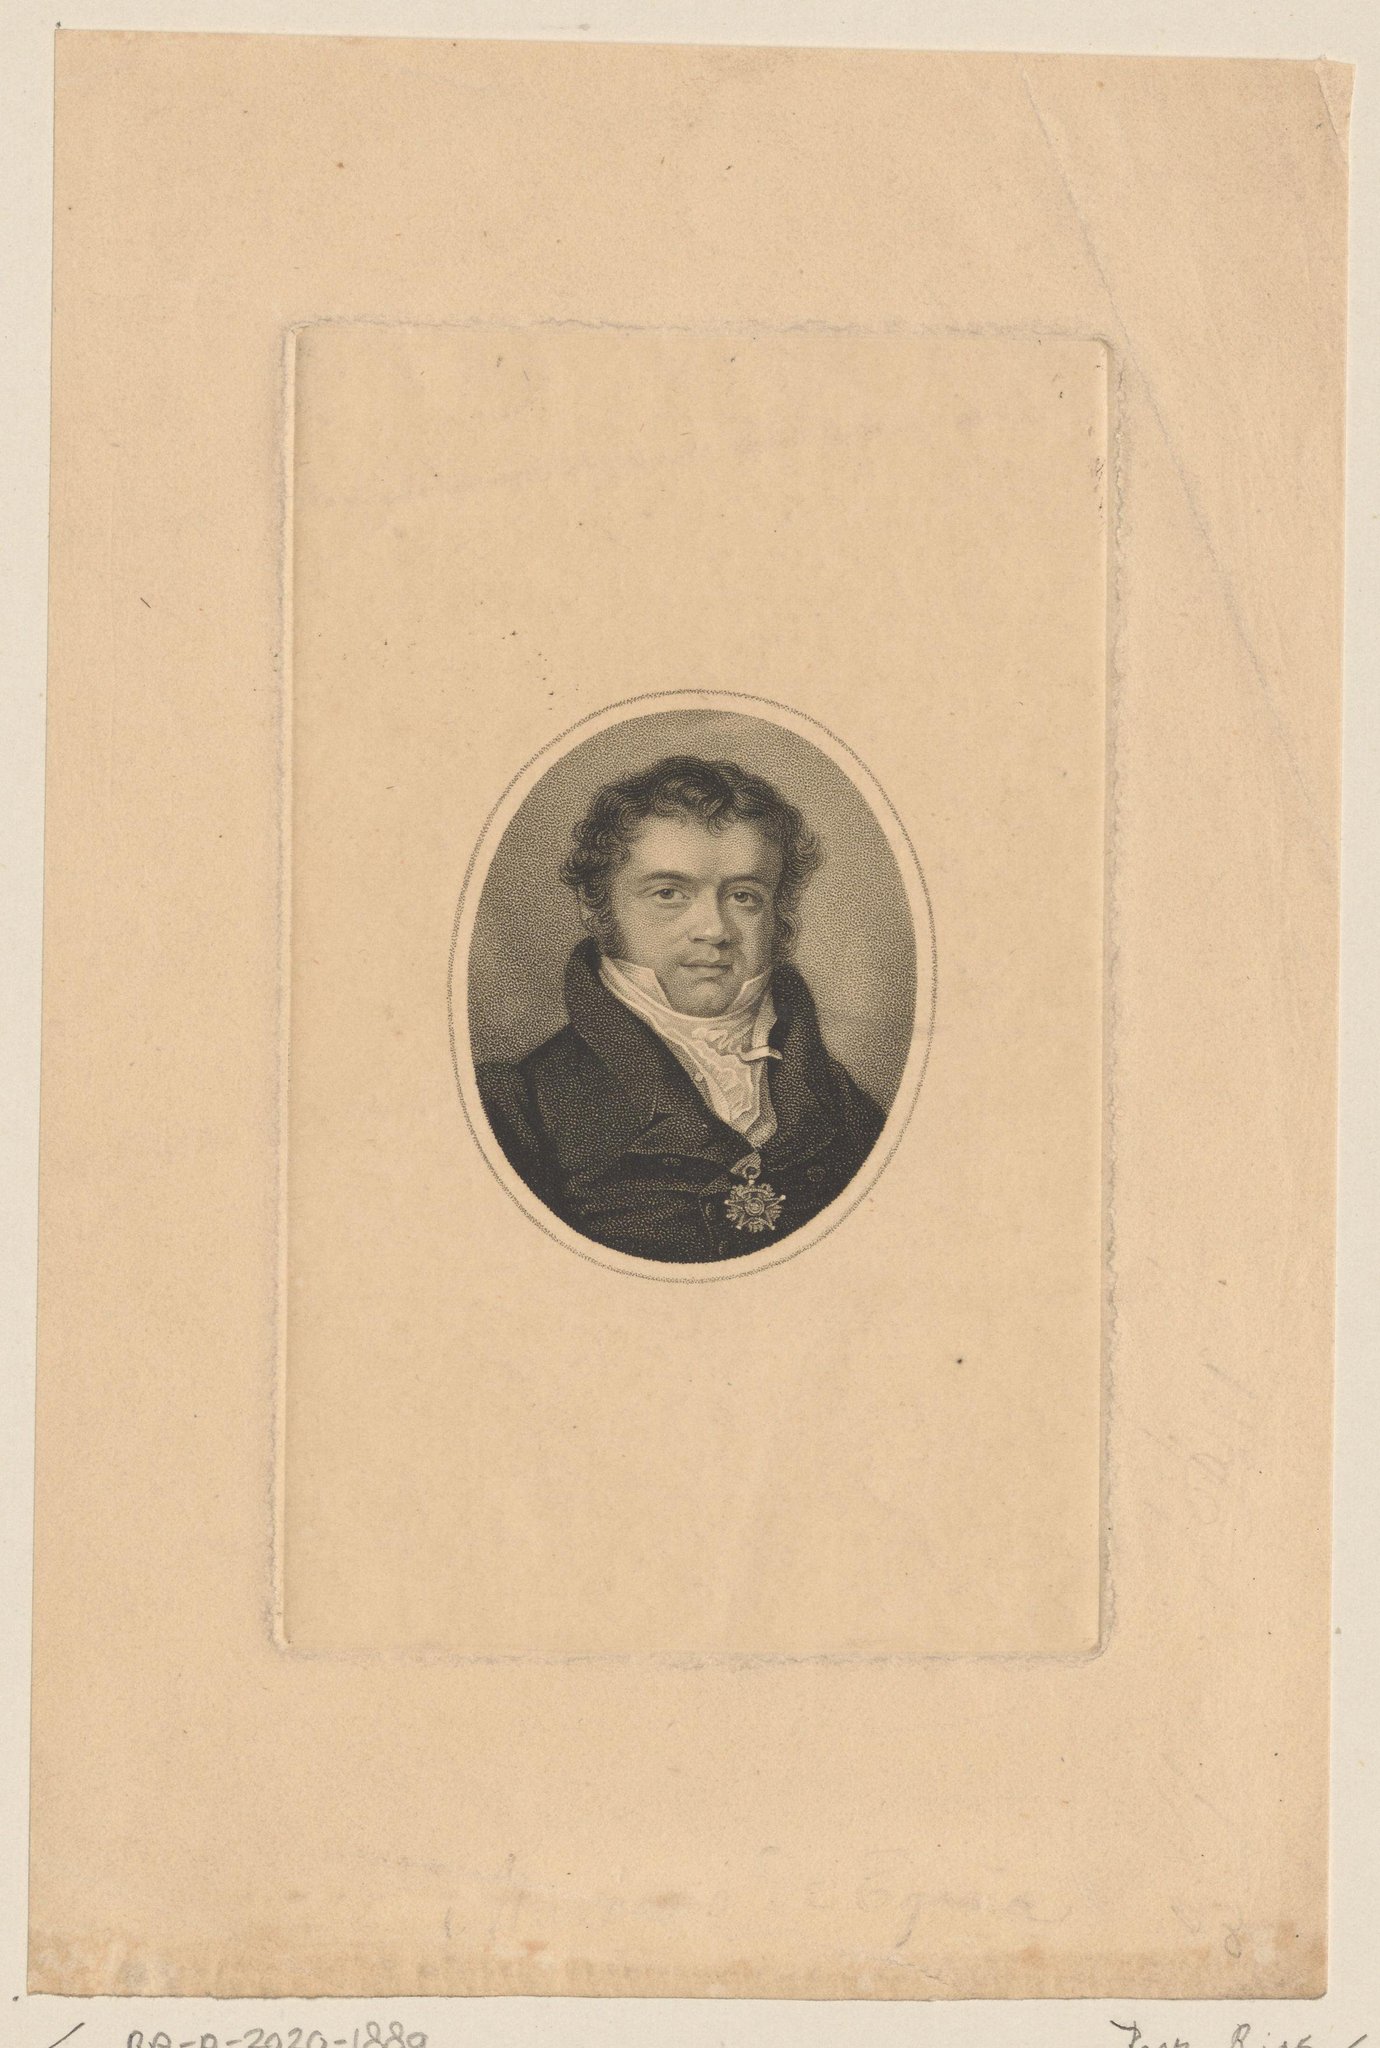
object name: print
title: Portret van Mariano Egaña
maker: Anonymous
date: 1820-1870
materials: paper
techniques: stippling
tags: historical persons, politician, e.g. party leader